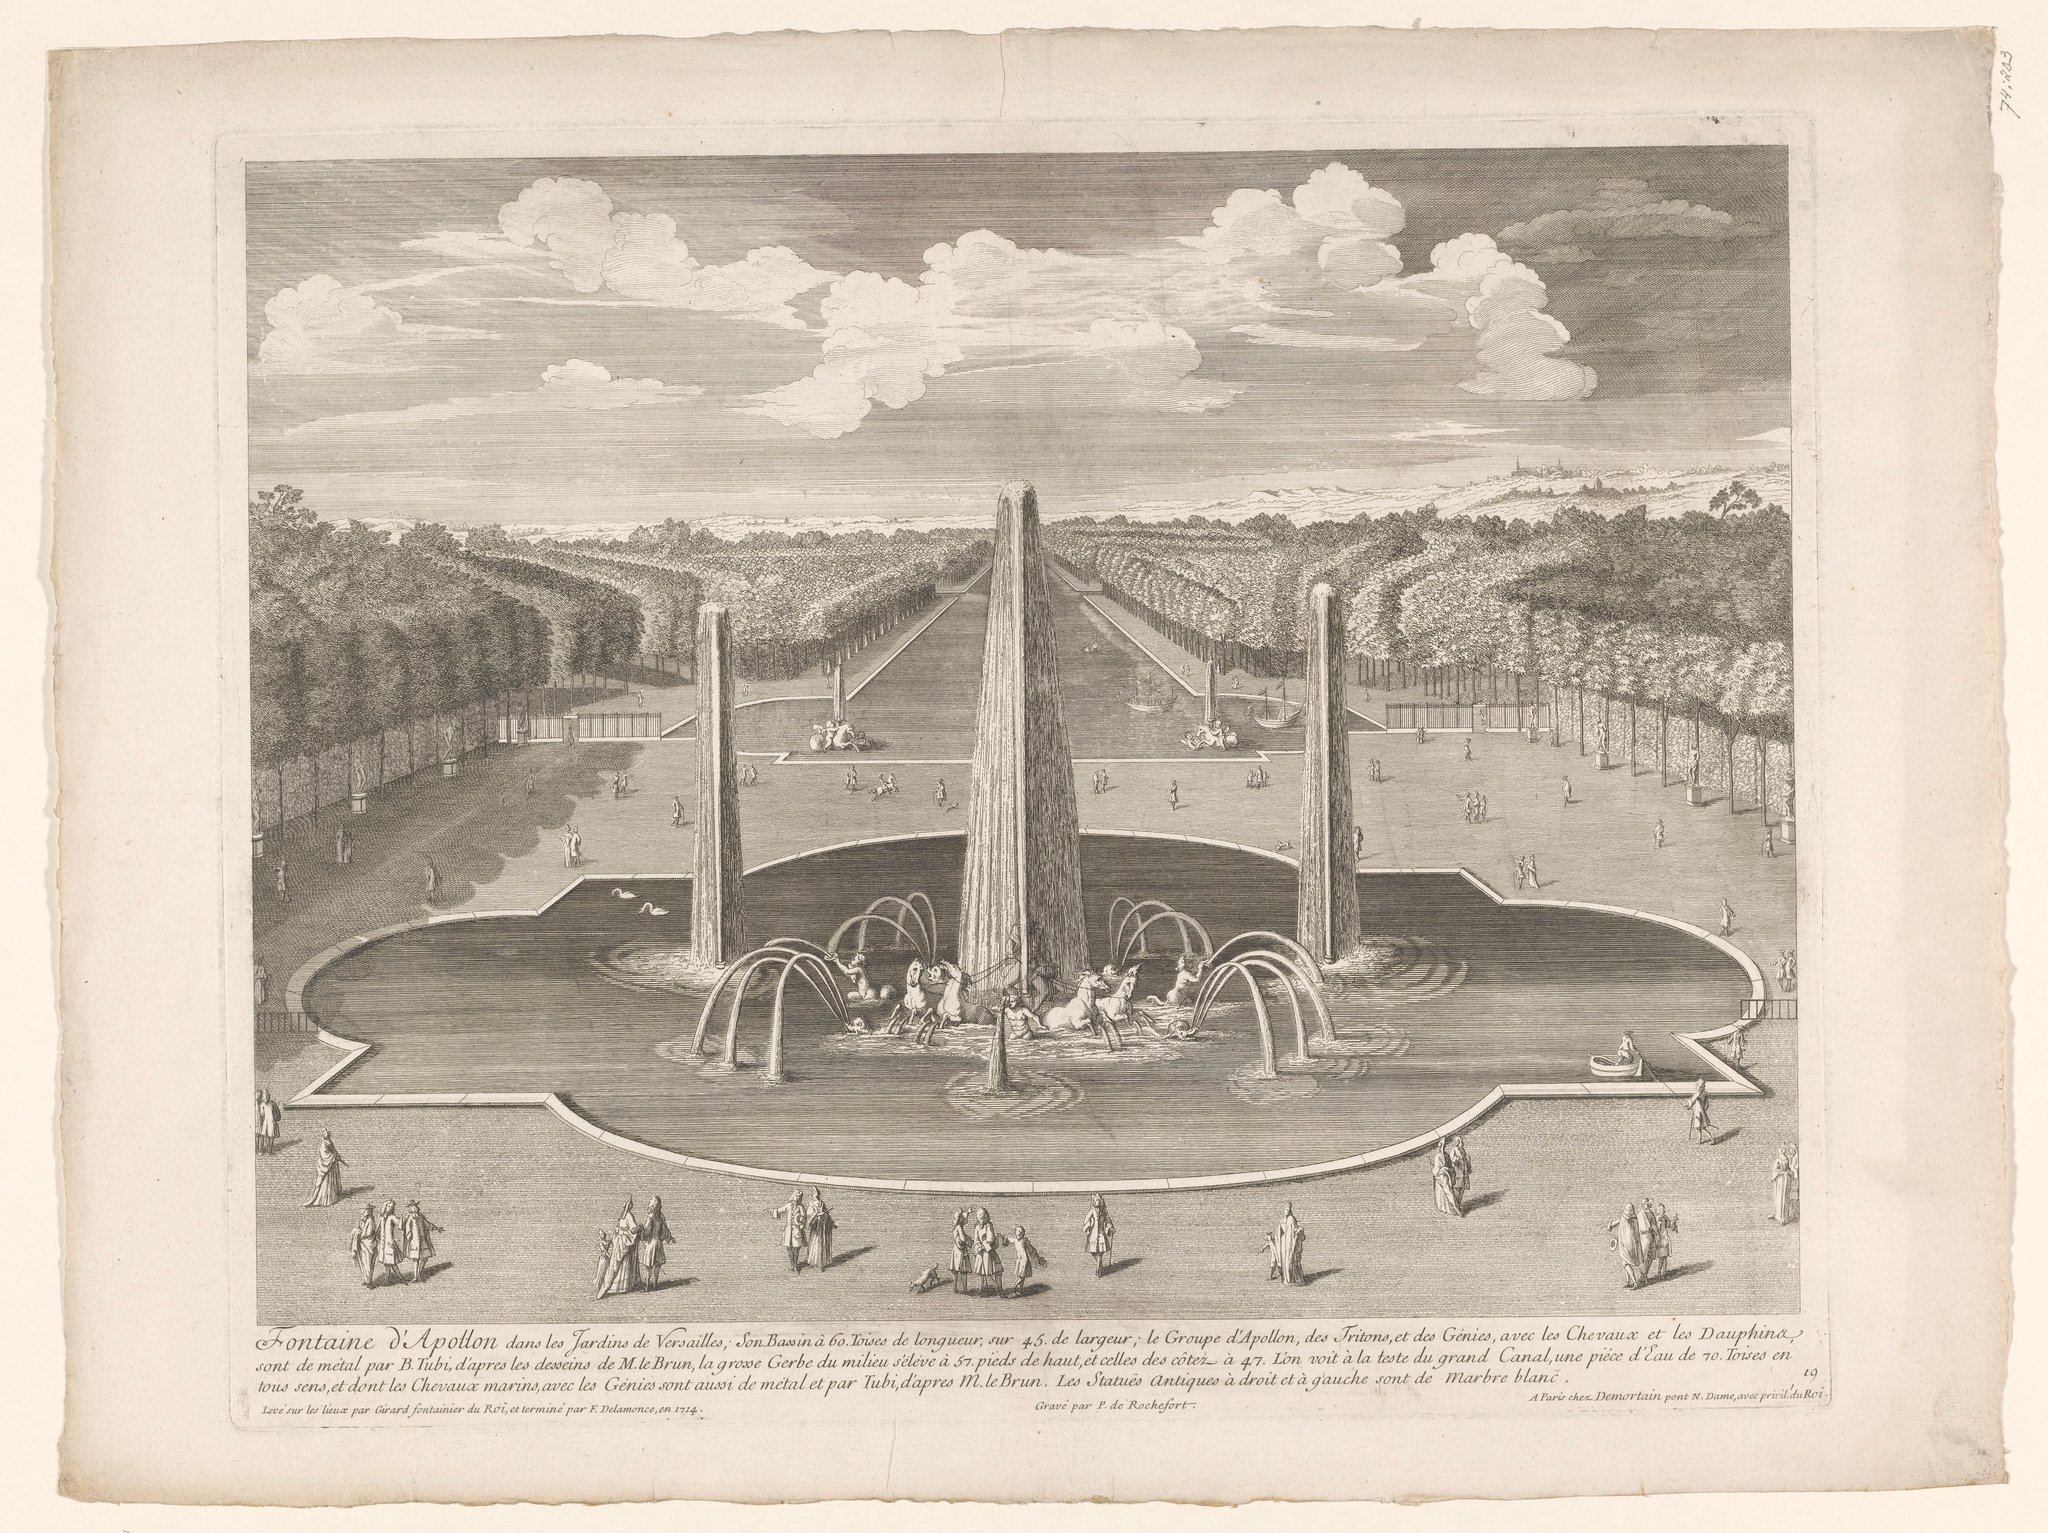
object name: print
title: Fontein van Apollo in de tuin van Versailles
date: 1715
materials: paper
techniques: engraving, etching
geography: paris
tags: garden fountain, french or architectonic garden; formal garden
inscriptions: collector's mark: Lugt 2760, collector's mark: Lugt 2228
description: Prent ook gebruikt in: Les Plans, Profils, Et Elevations, Des Ville, Et Château De Versailles (...). Parijs: Gilles de Demortain, [1715].